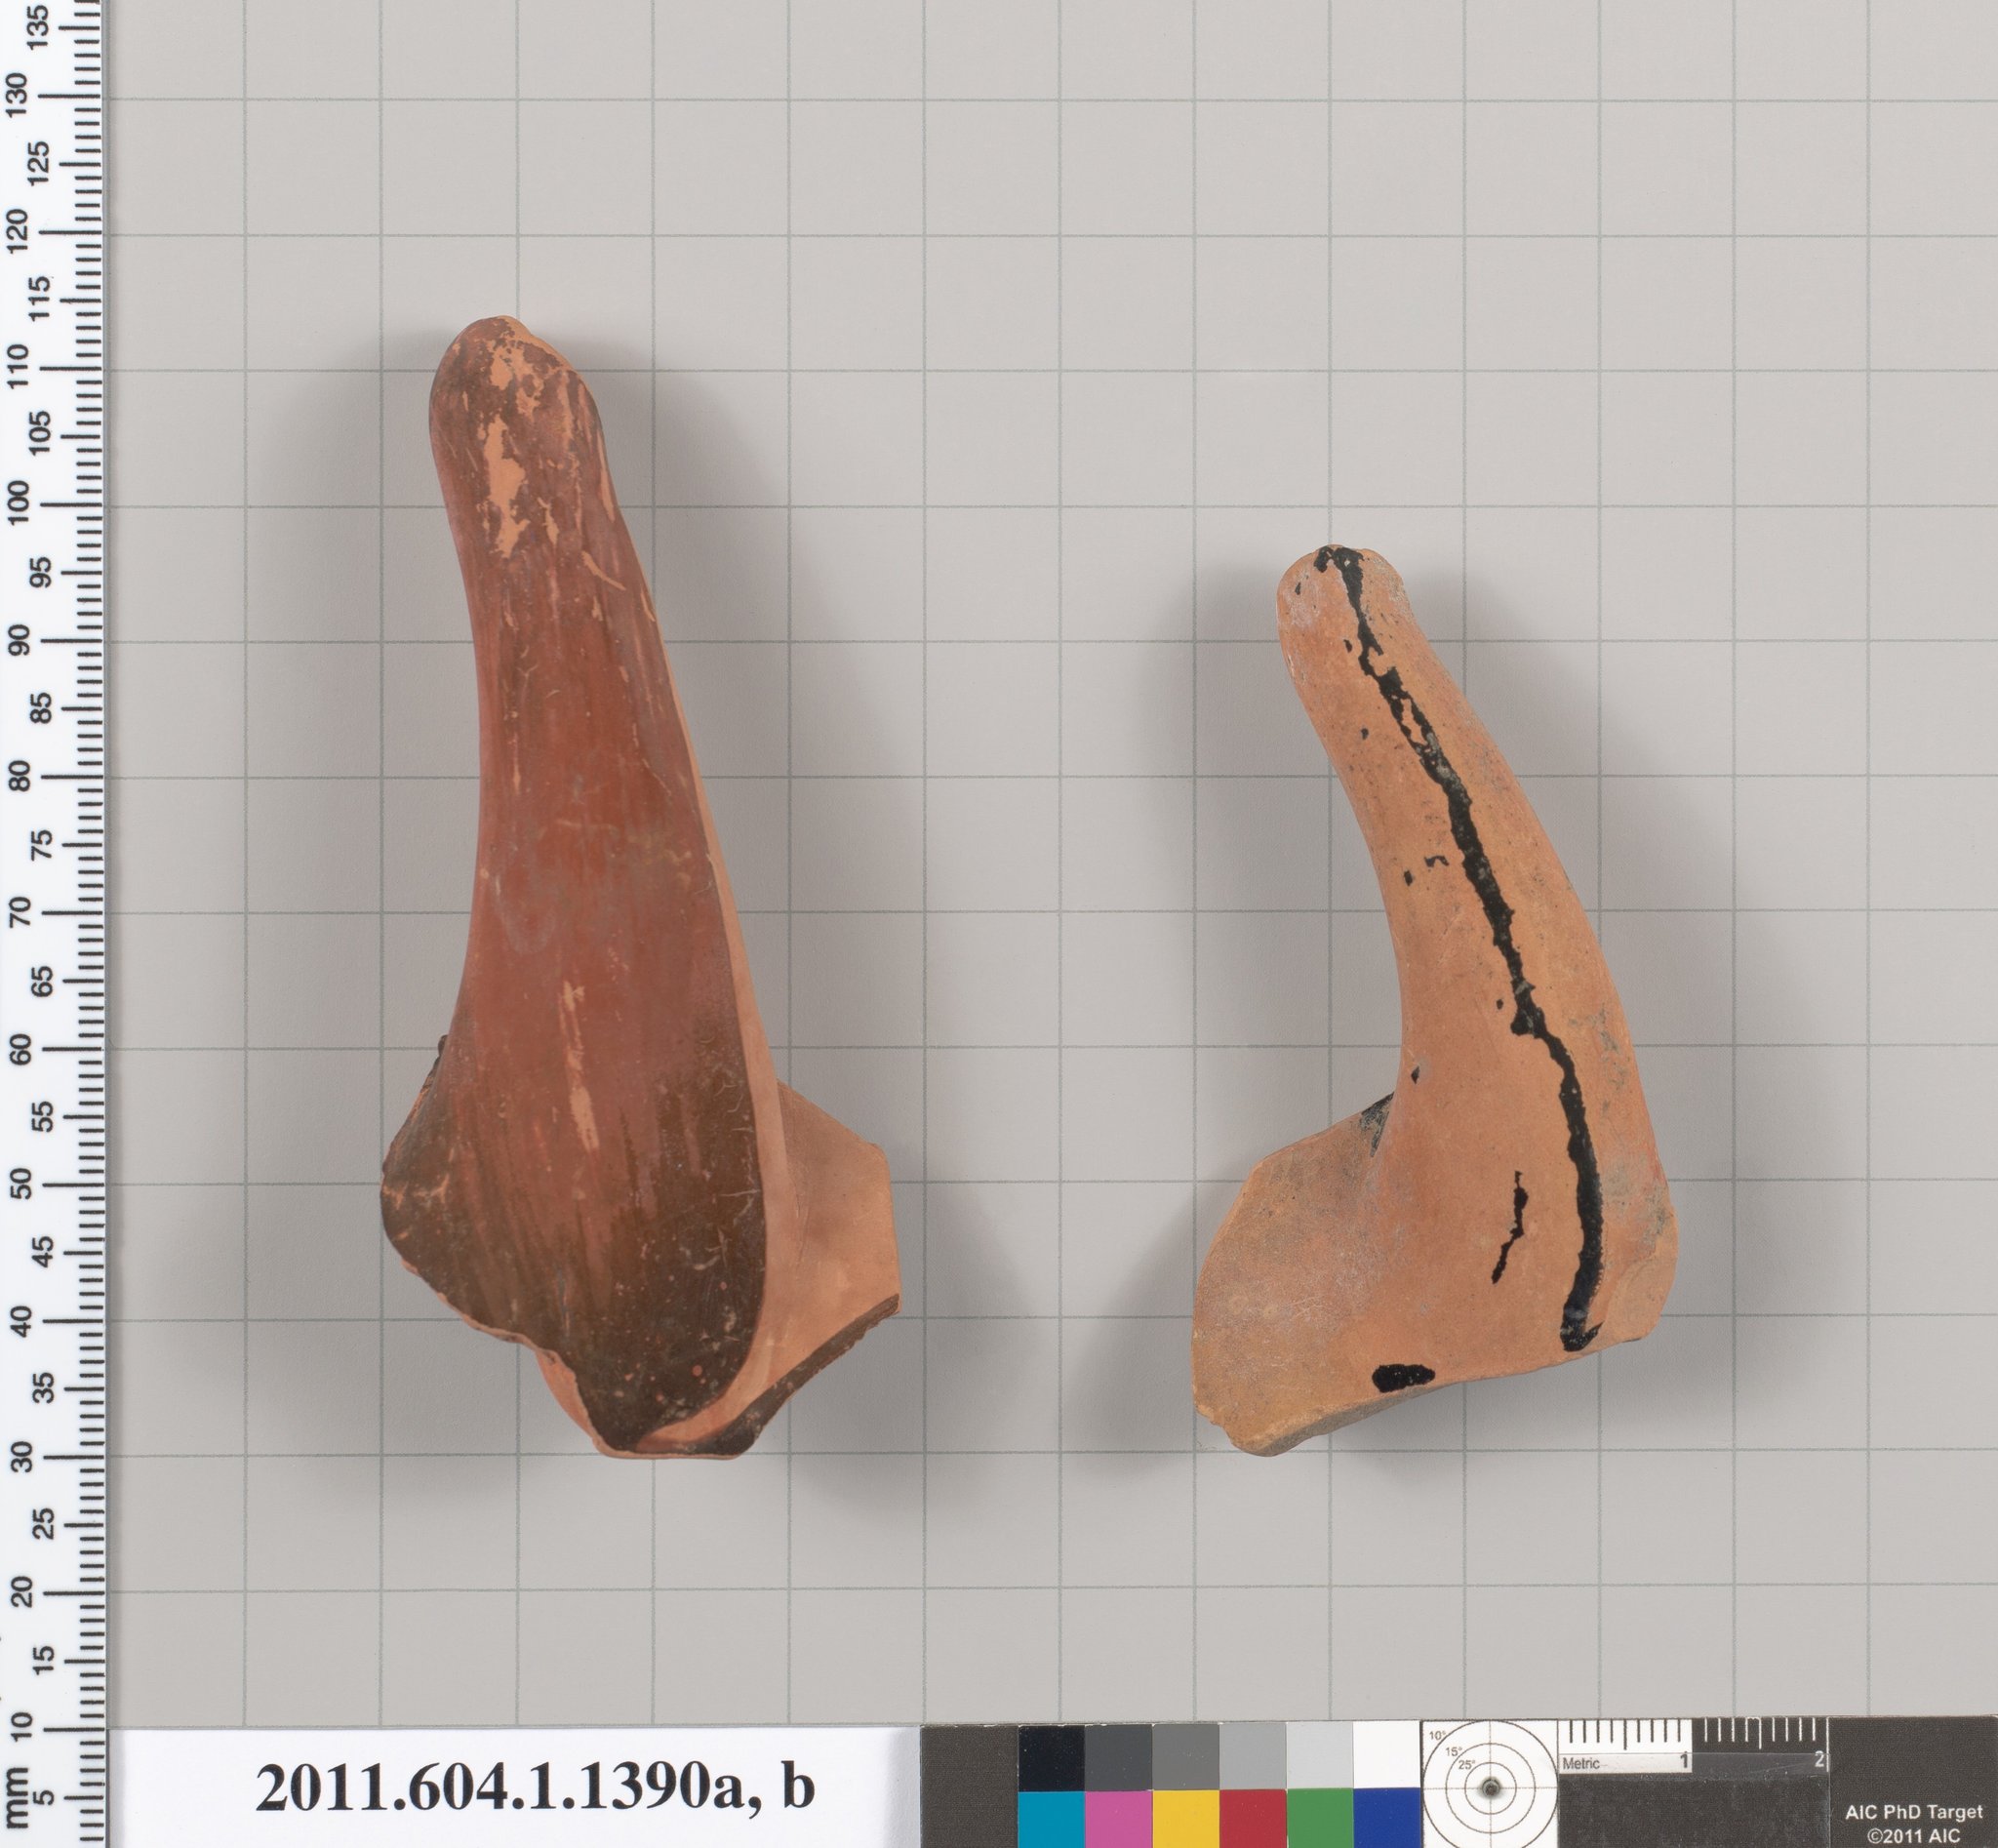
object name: kylix fragment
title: Terracotta fragments of kylikes (drinking cups)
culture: greek, attic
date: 500-401 BCE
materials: terracotta